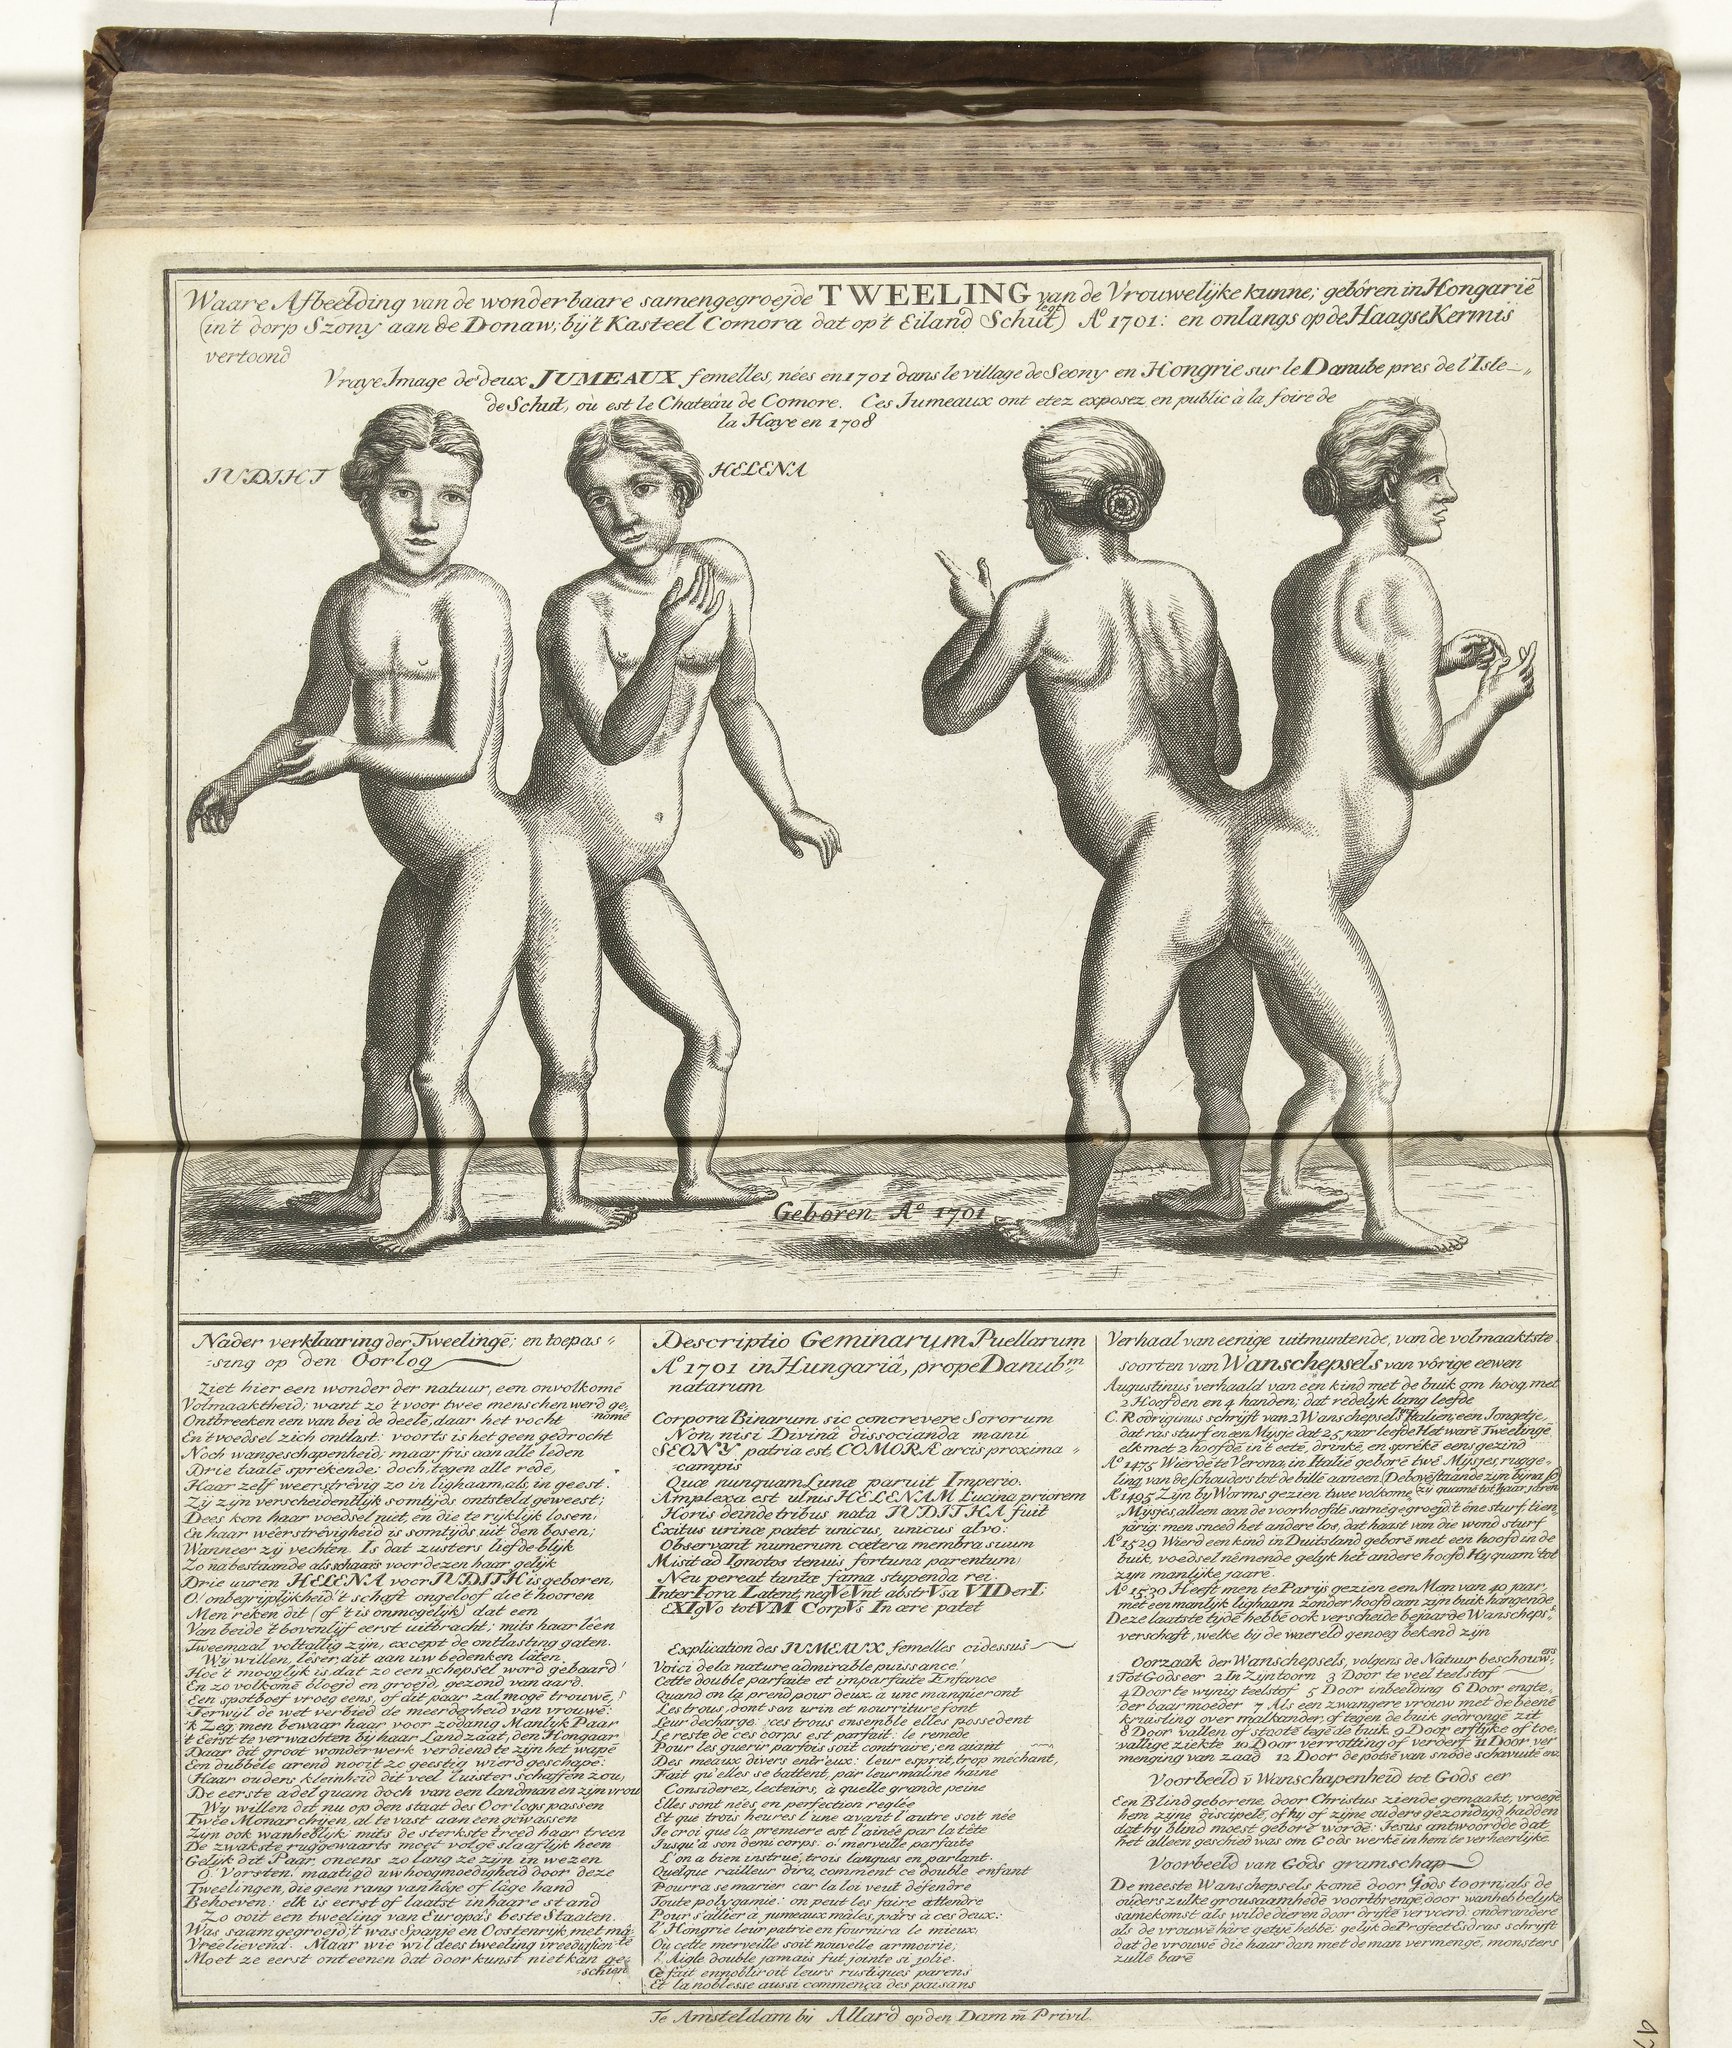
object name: print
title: Vraye Image de deux Jumeaux (...) exposez en public à la Foire de la Haye en 1708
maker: carel allard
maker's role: print maker, publisher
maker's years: 1648-1709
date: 1708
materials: paper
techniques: etching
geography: amsterdam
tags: siamese twins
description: Een Siamese tweeling van twee meisjes uit Hongarije, Judith en Helena, vertoond op de Haagse kermis in 1708. In de plaat een beschrijving en uitleg in 2 kolommen in het Nederlands en met een toepassing op de oorlogssituatie in het jaar 1708, in het midden verzen in het Latijn en Frans. Onderdeel van een reeks van 7 spotprenten op de Fransen en bondgenoten uit het jaar 1707 (en 1708). Onderdeel van het prentwerk uitgegeven onder de verzameltitel 't Lust-Hof van Momus met de gebundelde series van spotprenten tijdens de jaren 1701-1713 van de Spaanse Successieoorlog.